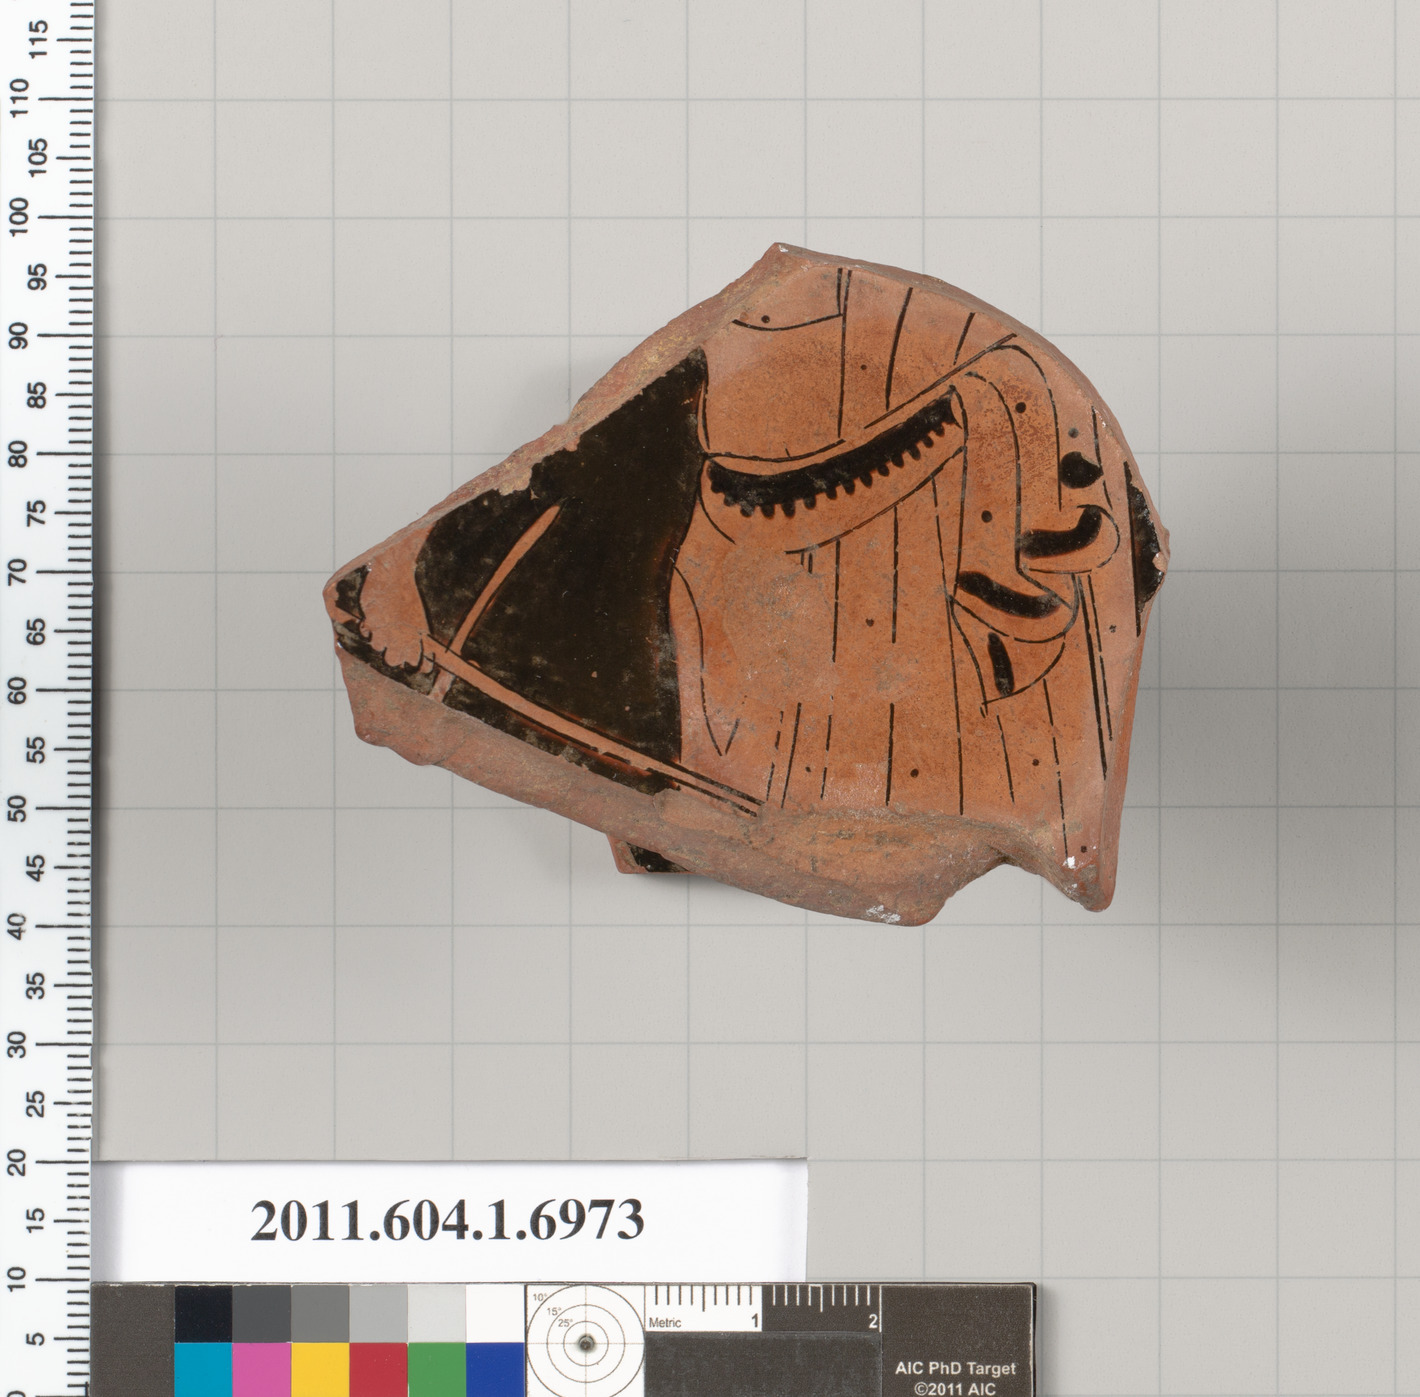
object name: kylix fragment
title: Terracotta fragment of a kylix (drinking cup)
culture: greek, attic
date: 490-470 BCE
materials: terracotta